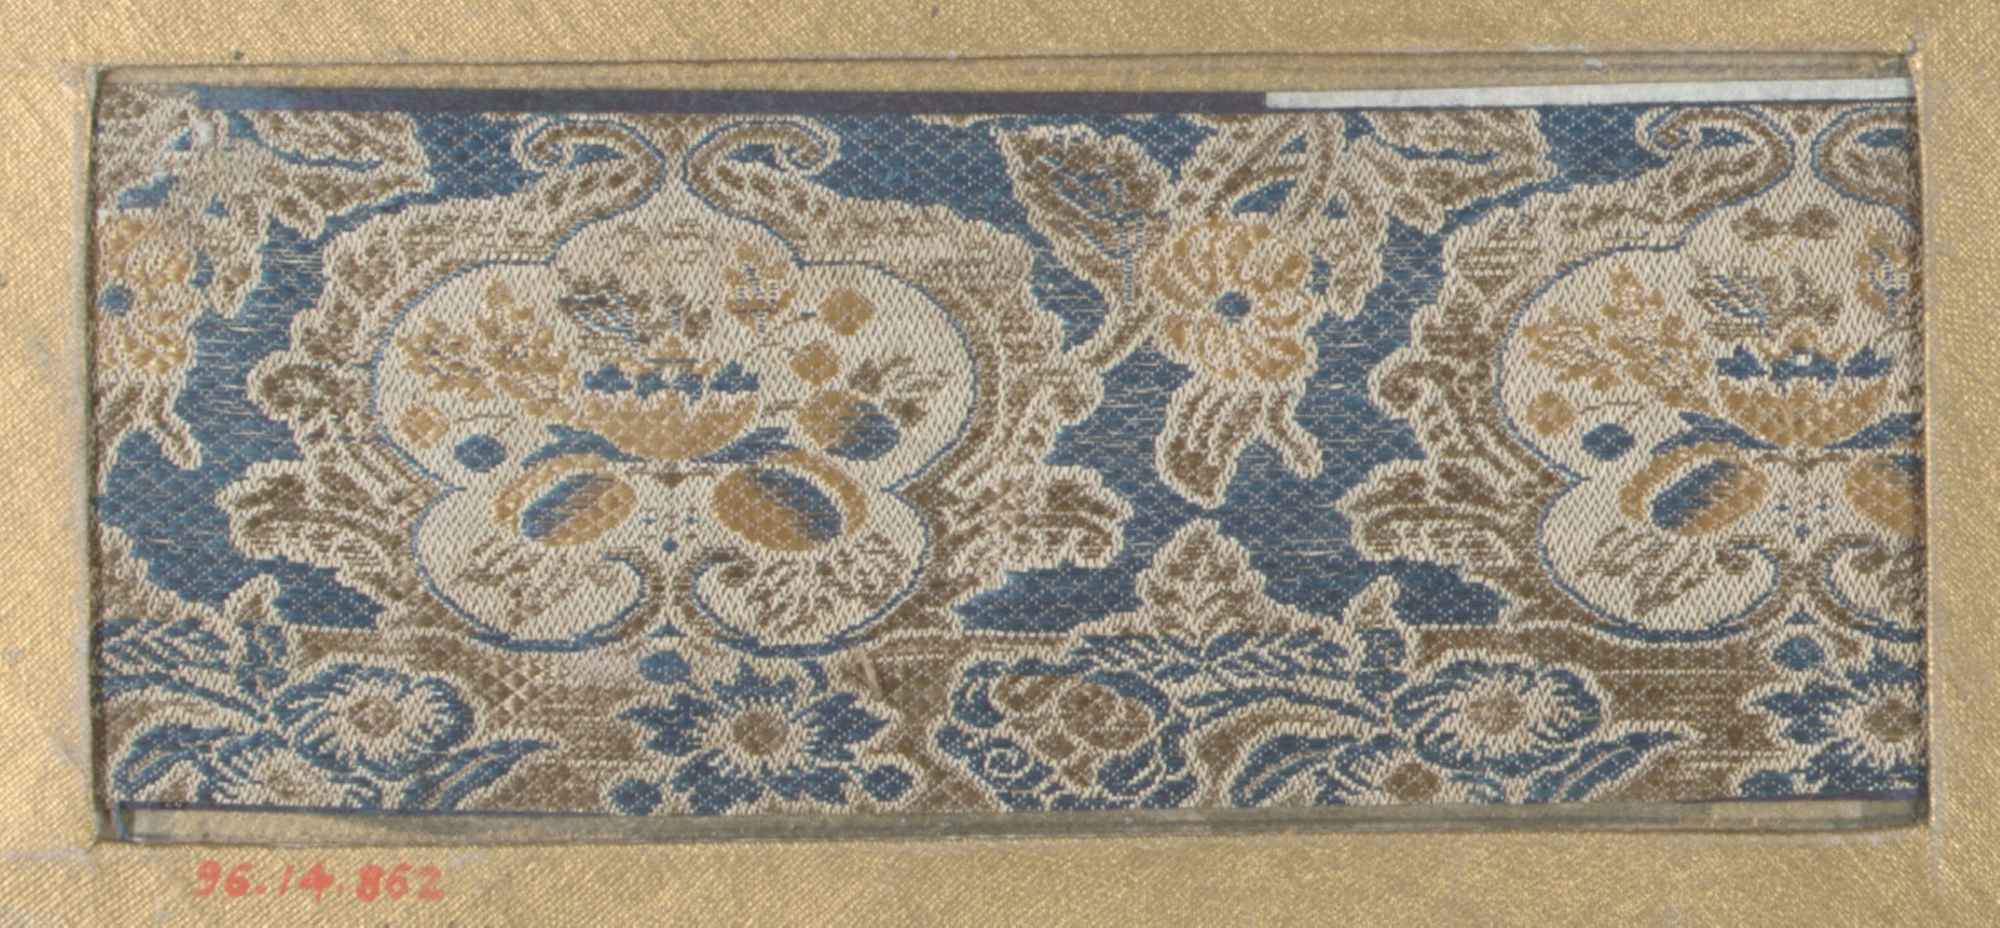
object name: piece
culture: japanese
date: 1701-1900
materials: silk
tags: leaves